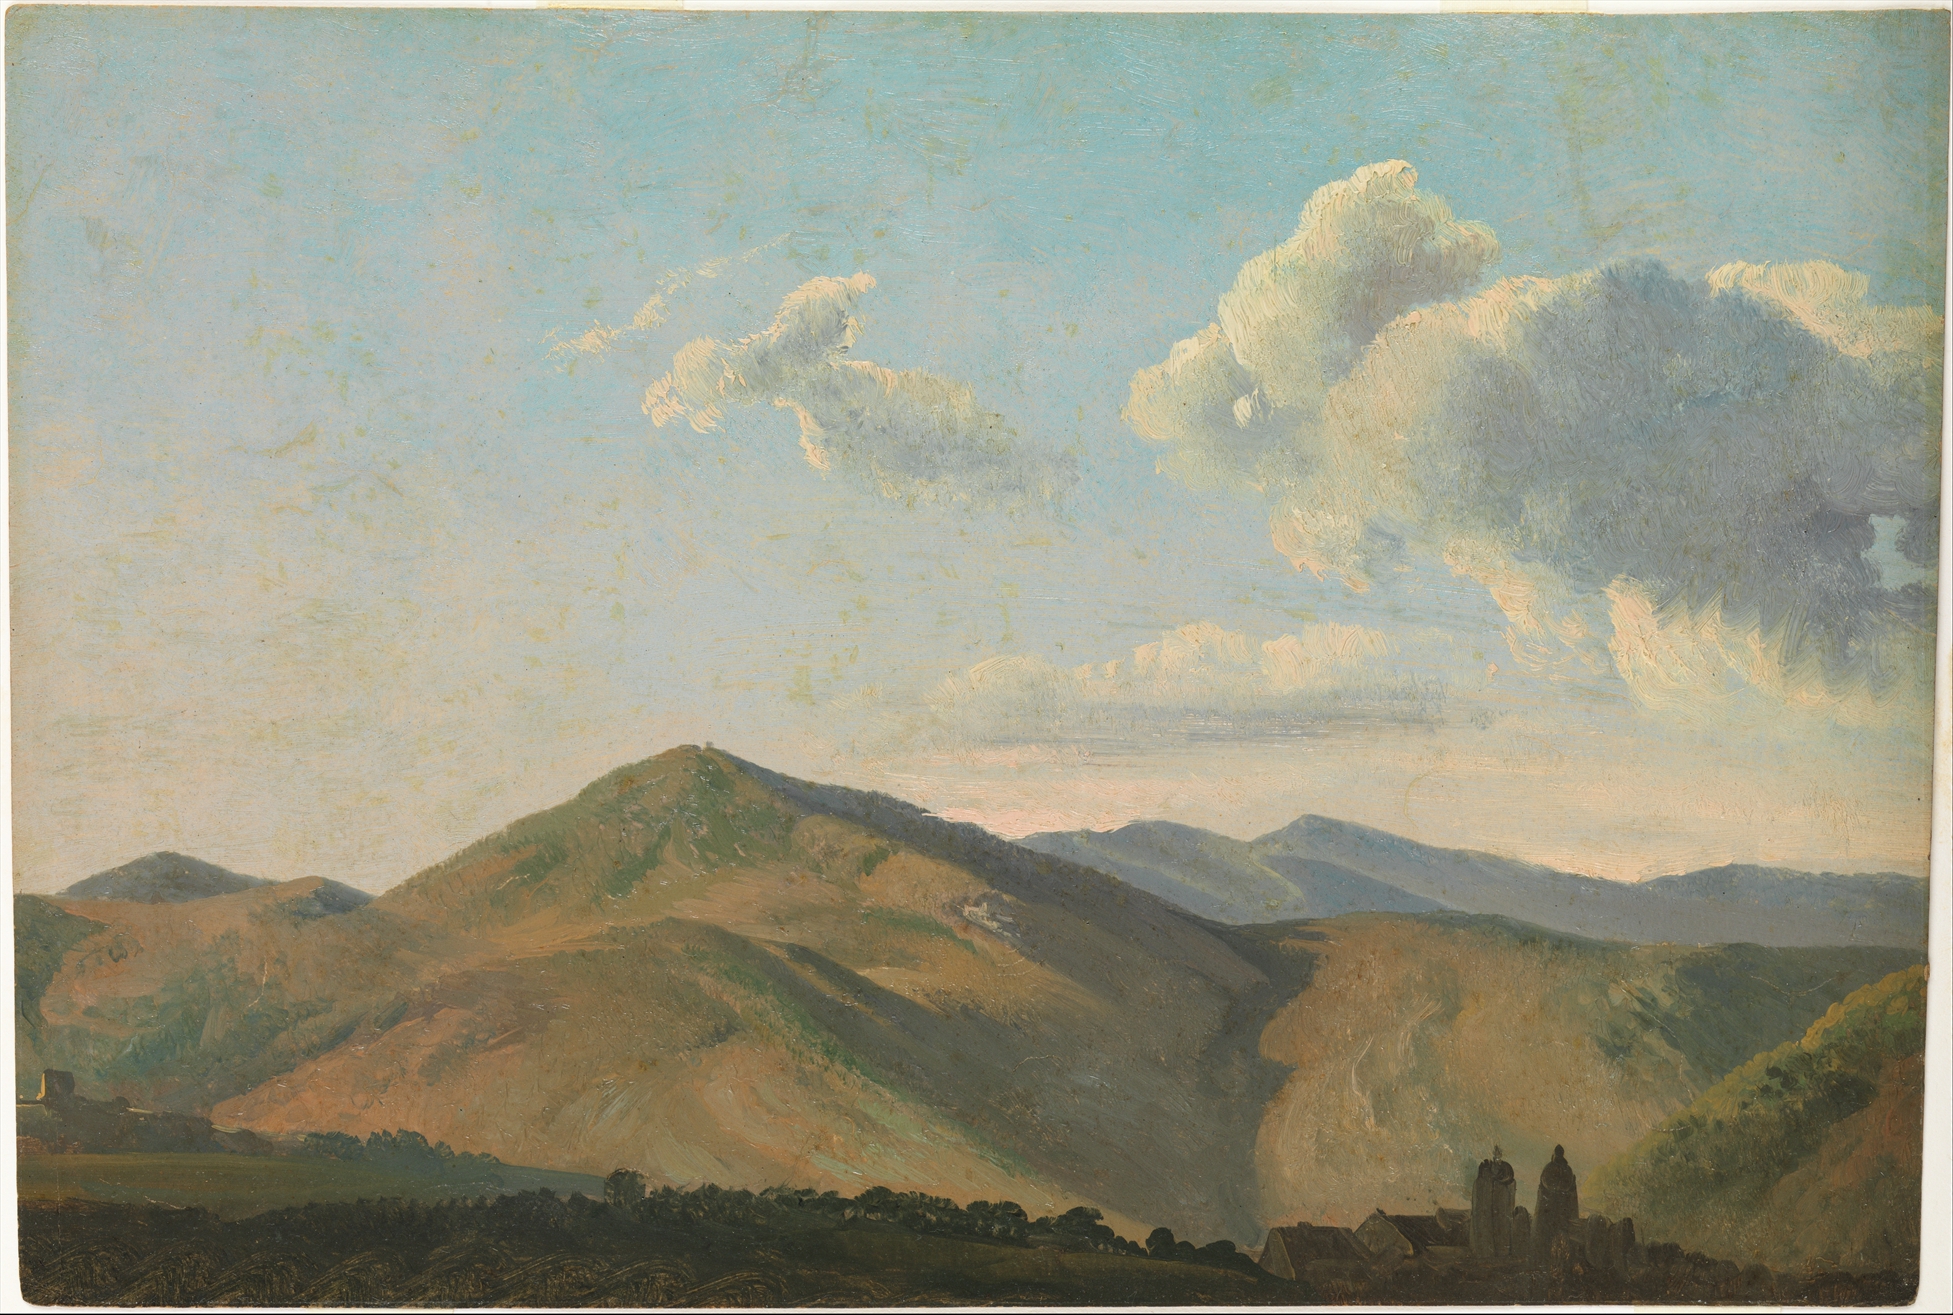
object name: painting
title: Mountainous Landscape at Vicovaro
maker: simon denis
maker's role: artist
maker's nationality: flemish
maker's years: 1755-1813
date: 1786-1797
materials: oil, paper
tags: mountains,landscapes